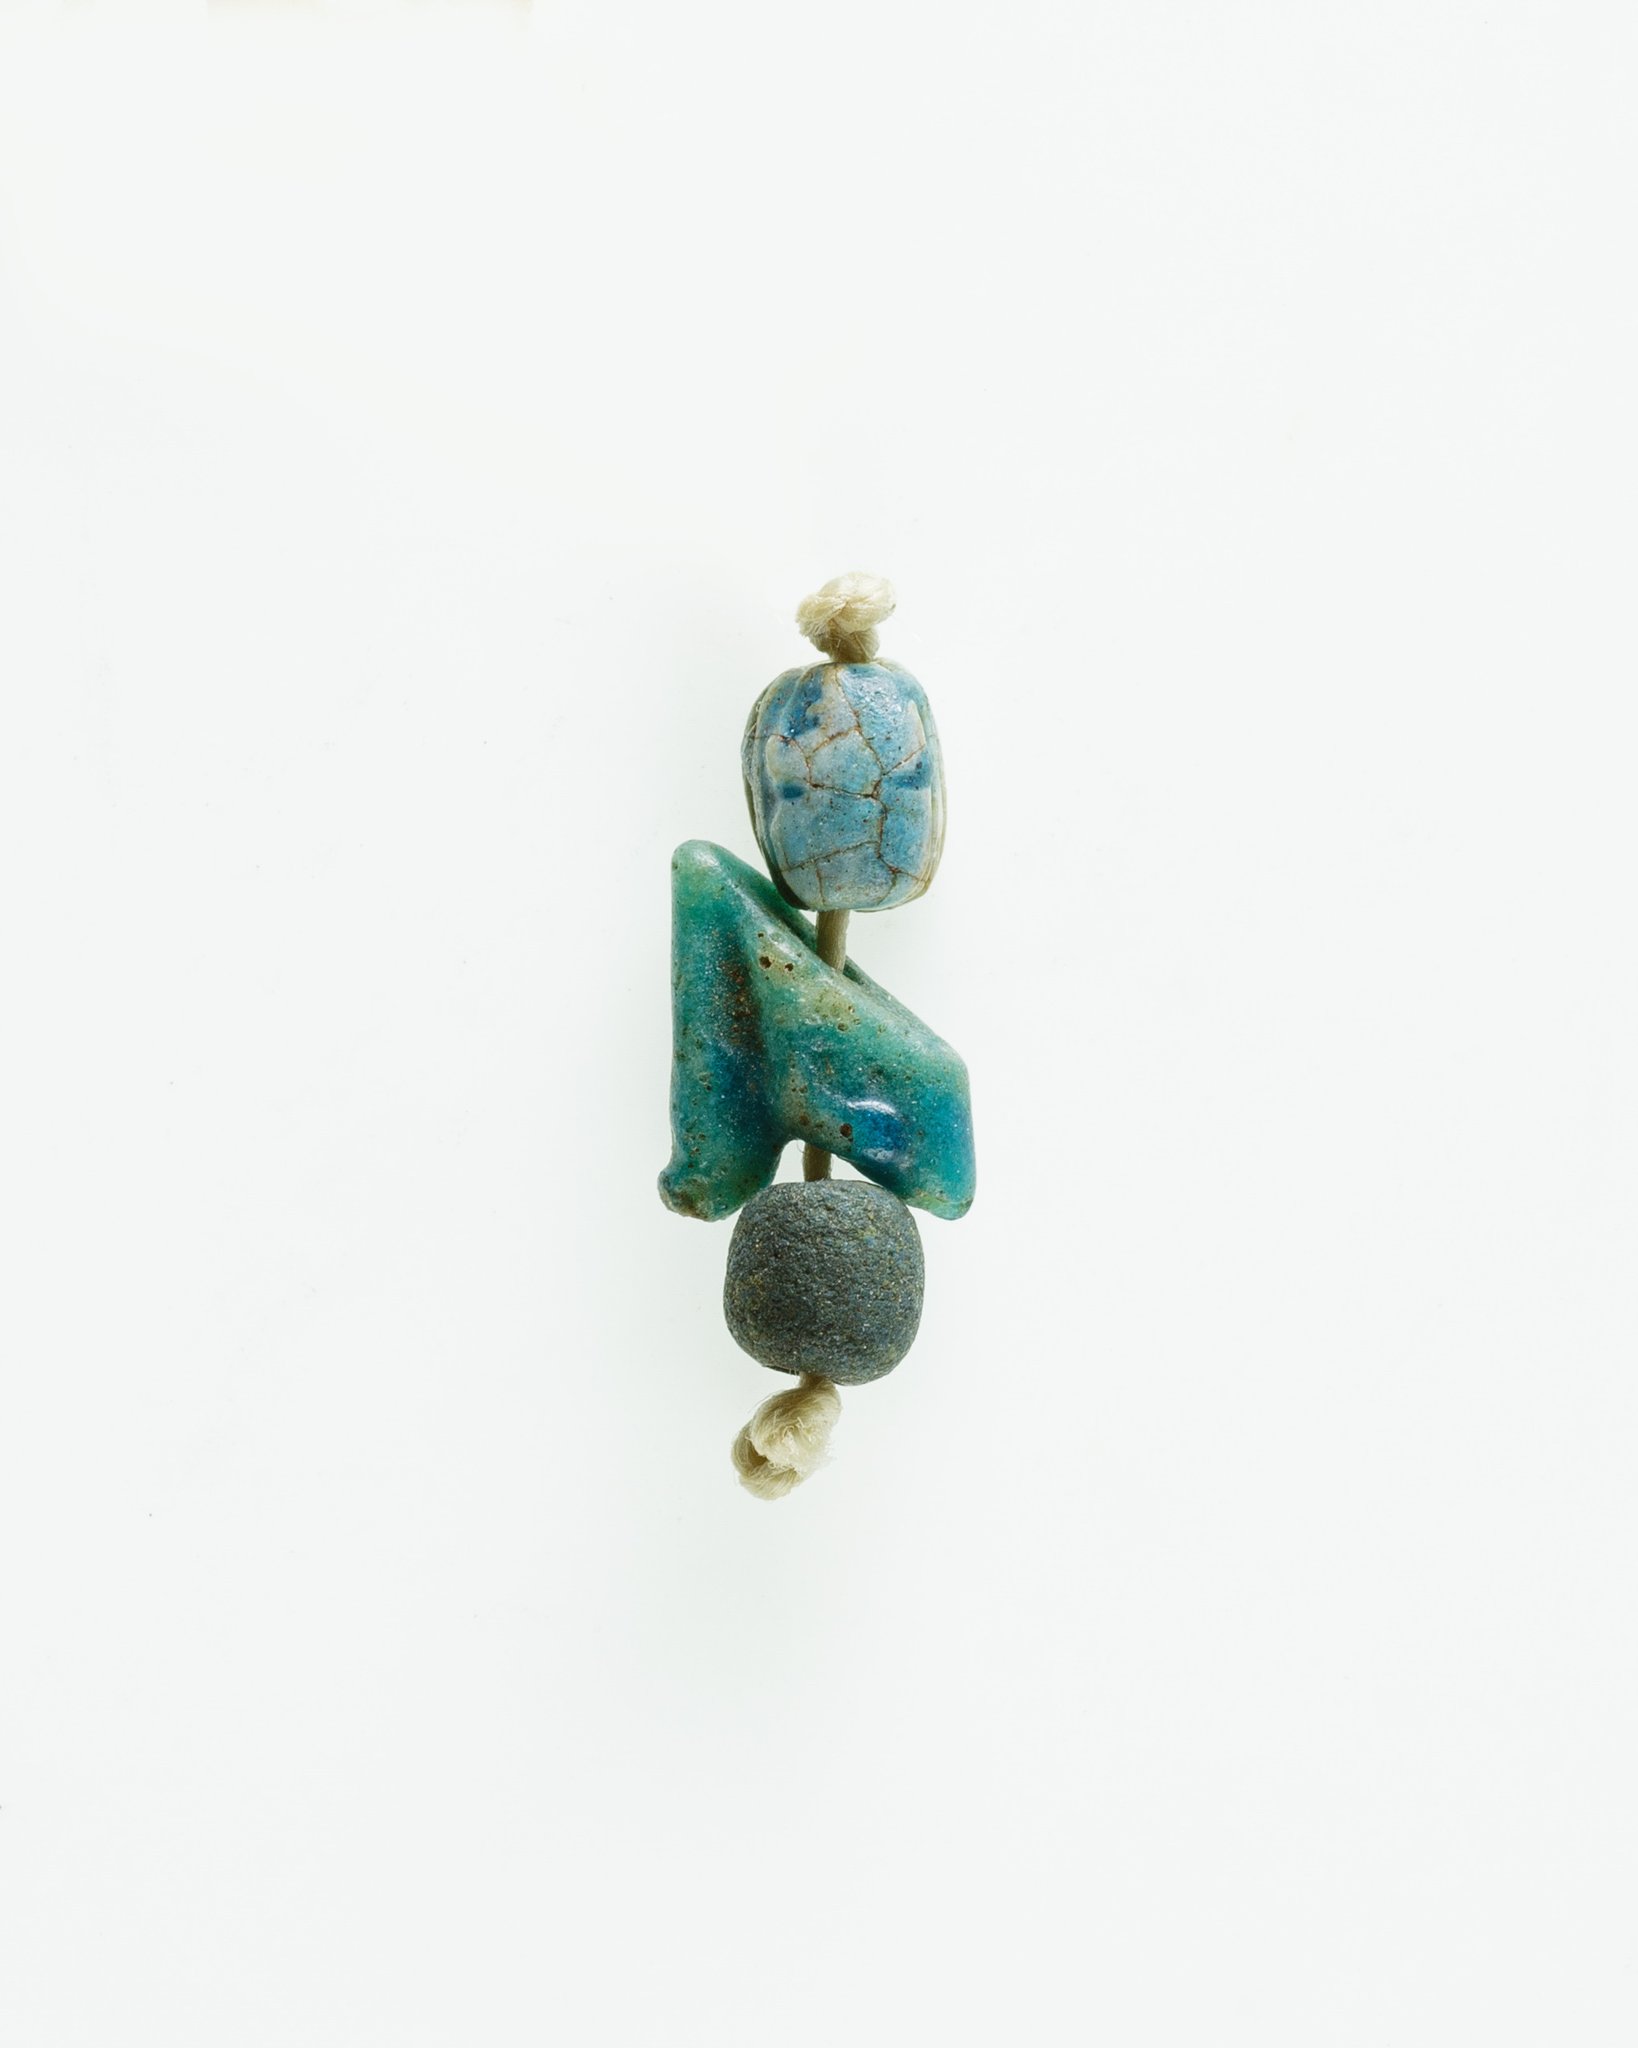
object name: scarab, hieroglyph, re, rdi ra formula, re give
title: Scarab Inscribed with a Blessing Related to Re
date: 1850-1640 BCE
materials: stone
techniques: glazing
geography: egypt